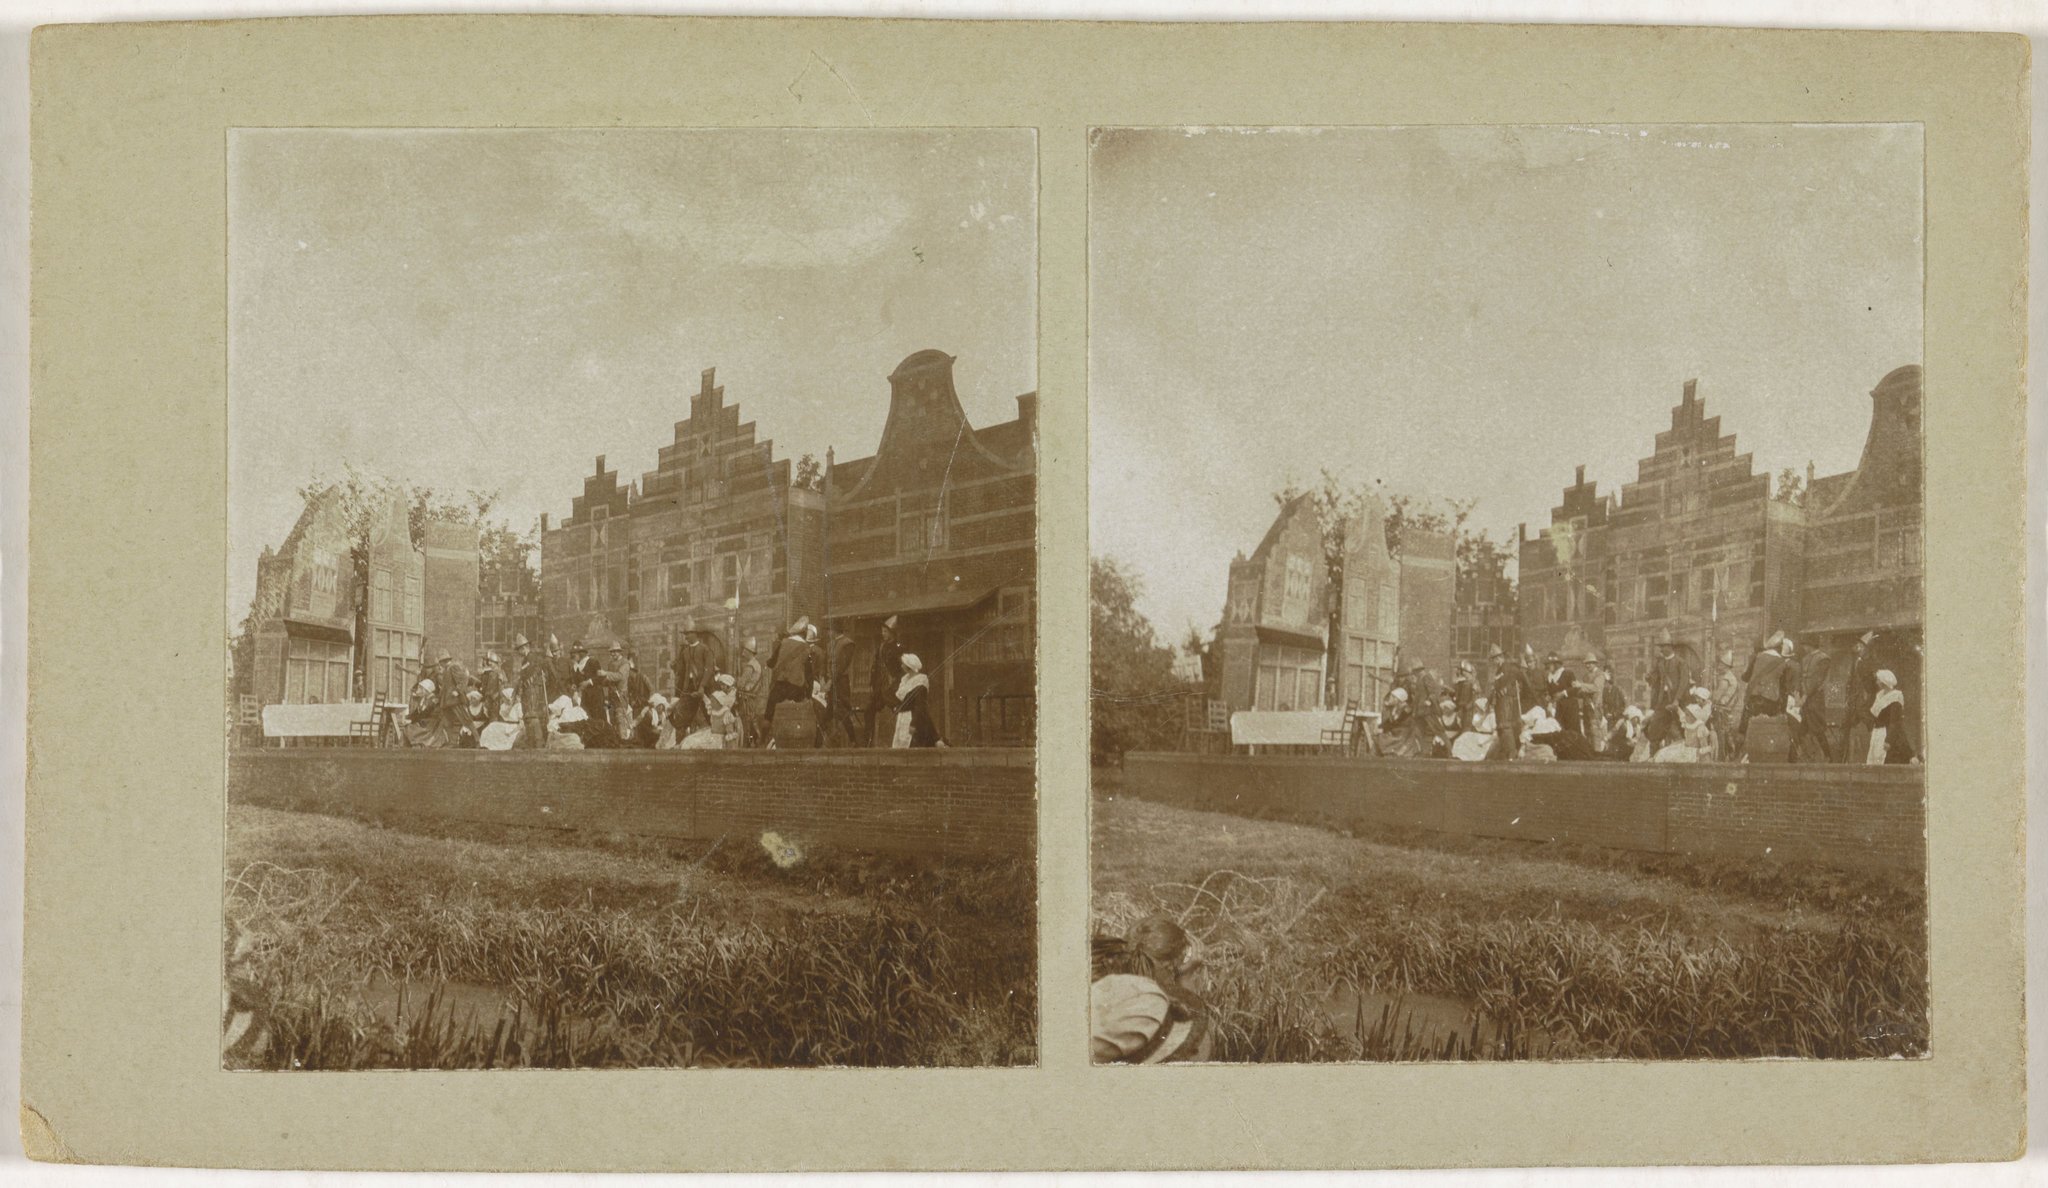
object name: stereograph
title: Opvoering van toneelstuk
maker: Anonymous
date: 1850-1920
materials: cardboard, paper, photographic support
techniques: gelatin silver print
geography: netherlands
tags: netherlands